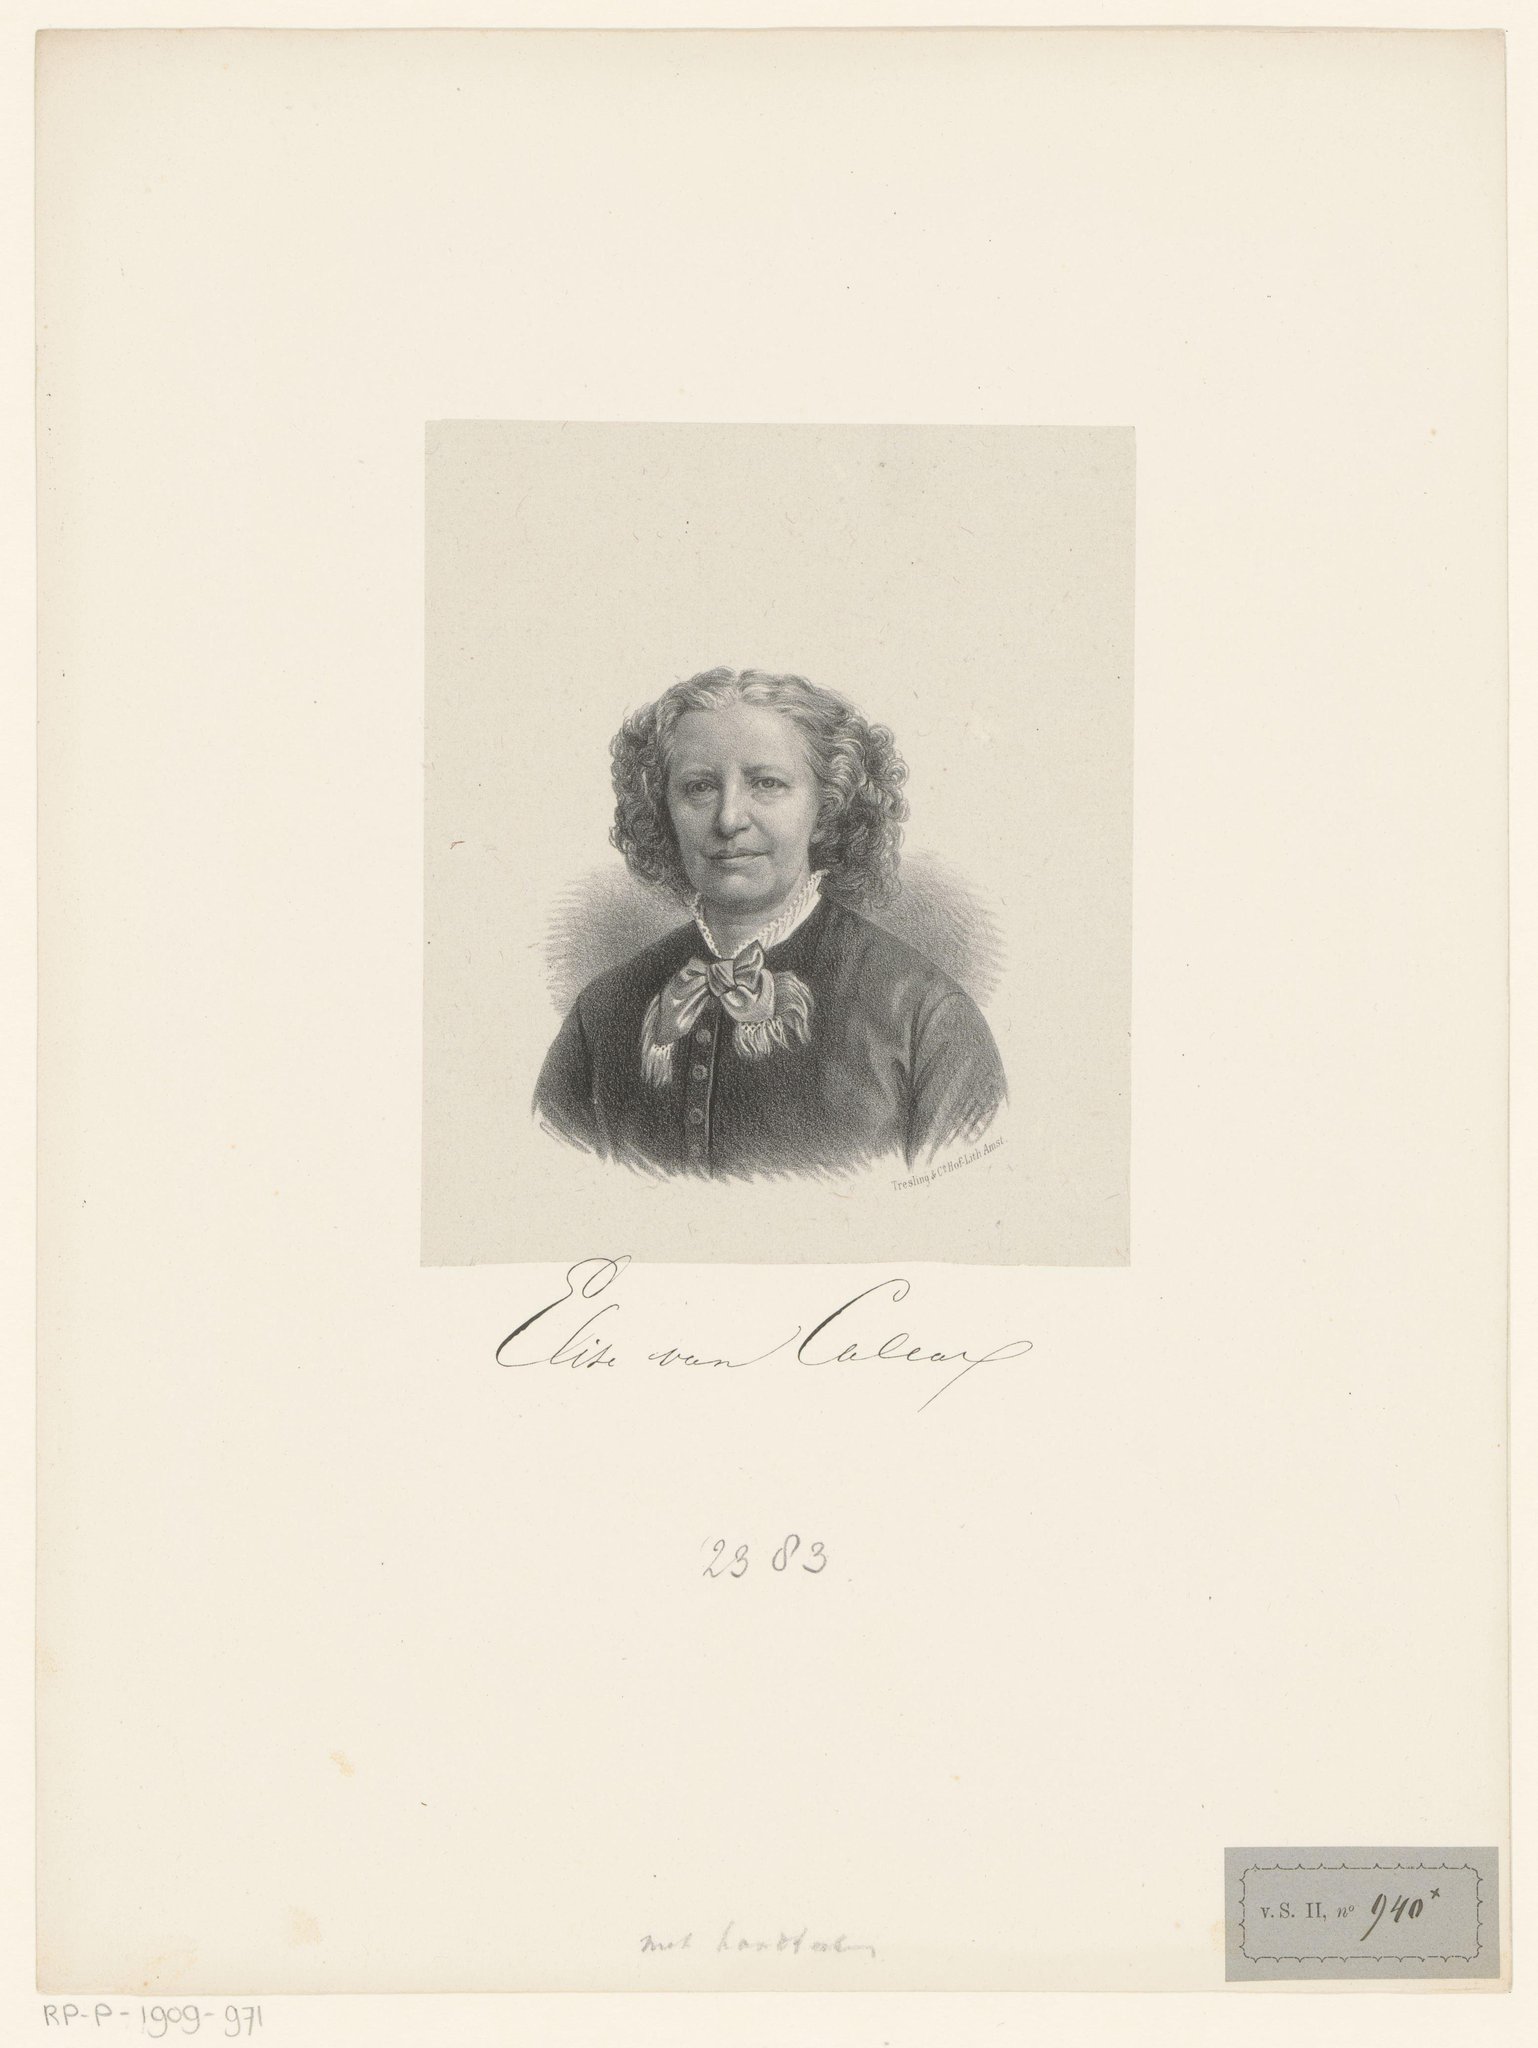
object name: print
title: Portret van Elise van Calcar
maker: Anonymous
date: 1858-1904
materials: paper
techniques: lithograph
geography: amsterdam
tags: amsterdam, the hague, elise van calcar, historical persons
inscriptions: collector's mark: Lugt 2228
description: Onder het portret de signatuur van de geportretteerde.